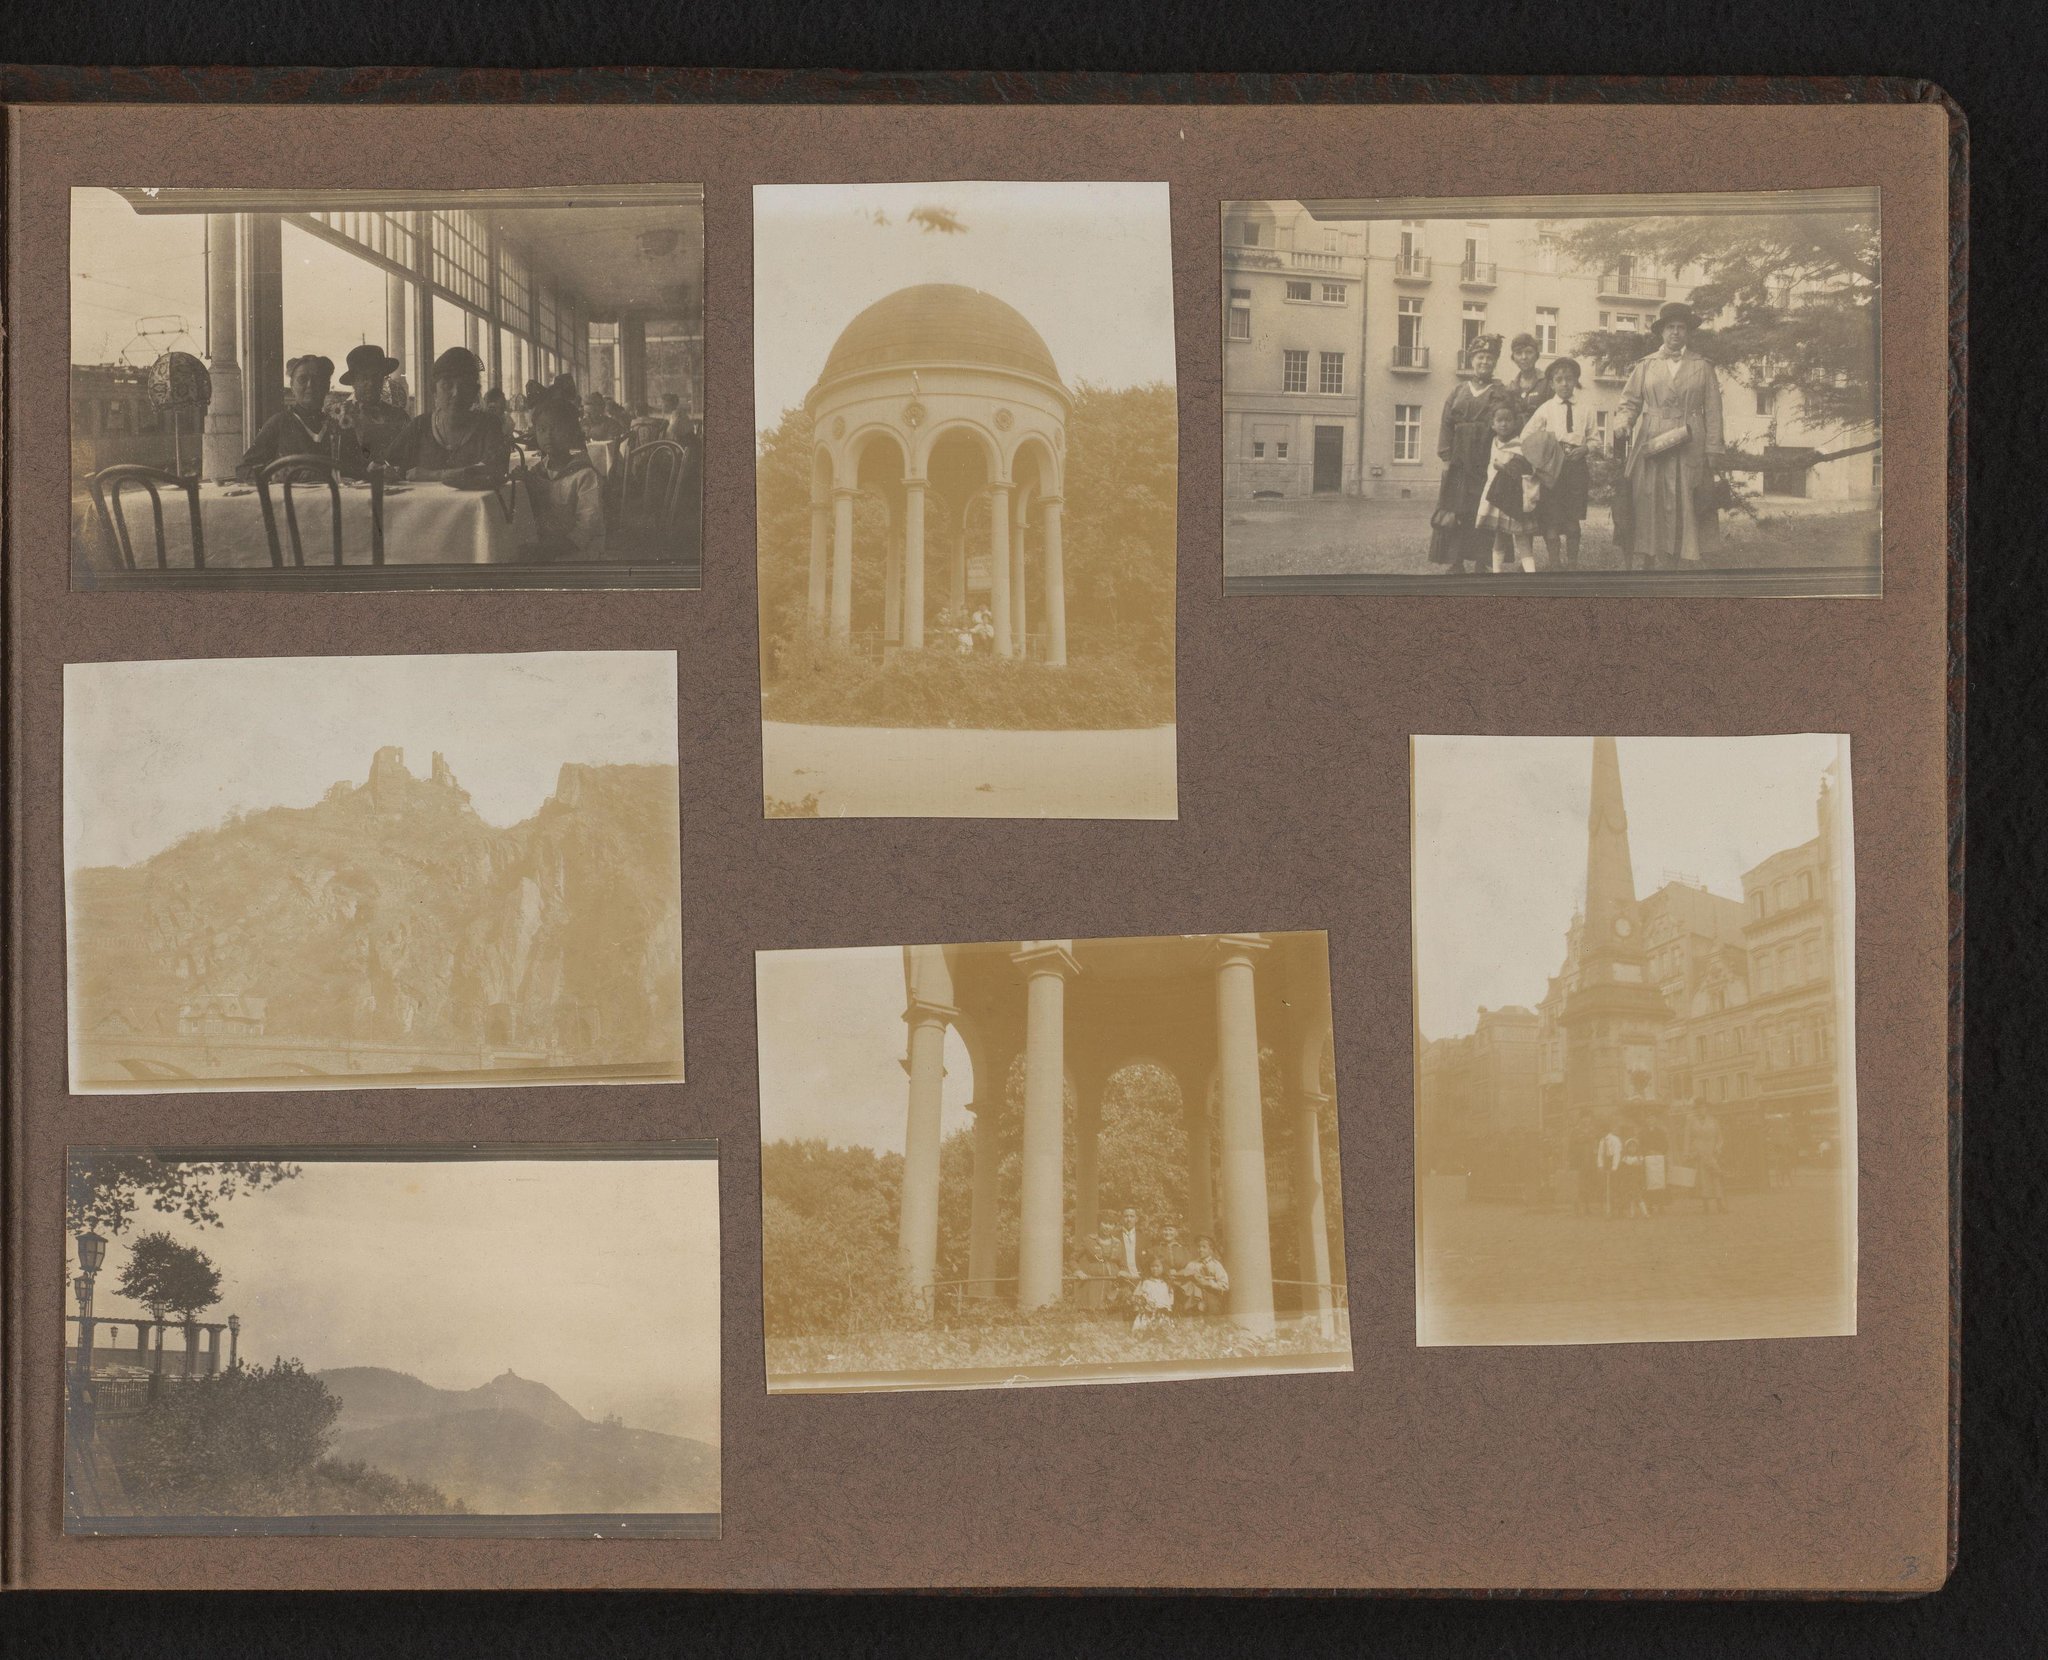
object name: photograph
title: Zeven foto's van de familie en monumenten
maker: frédéric gabriël dumas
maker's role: engineer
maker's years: 1886-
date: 1919-1923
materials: cardboard, photographic support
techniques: gelatin silver print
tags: surabaya, paris, beatrice jacqueline eveline dumas, java, outing, pleasure trip, europe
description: Blad met zeven foto's van de familie, monumenten in steden en uitkijkpunten. Onderdeel van een fotoalbum over de kindertijd van Eef Dumas met de familie op reis door Europa, ca. 1919-1923.